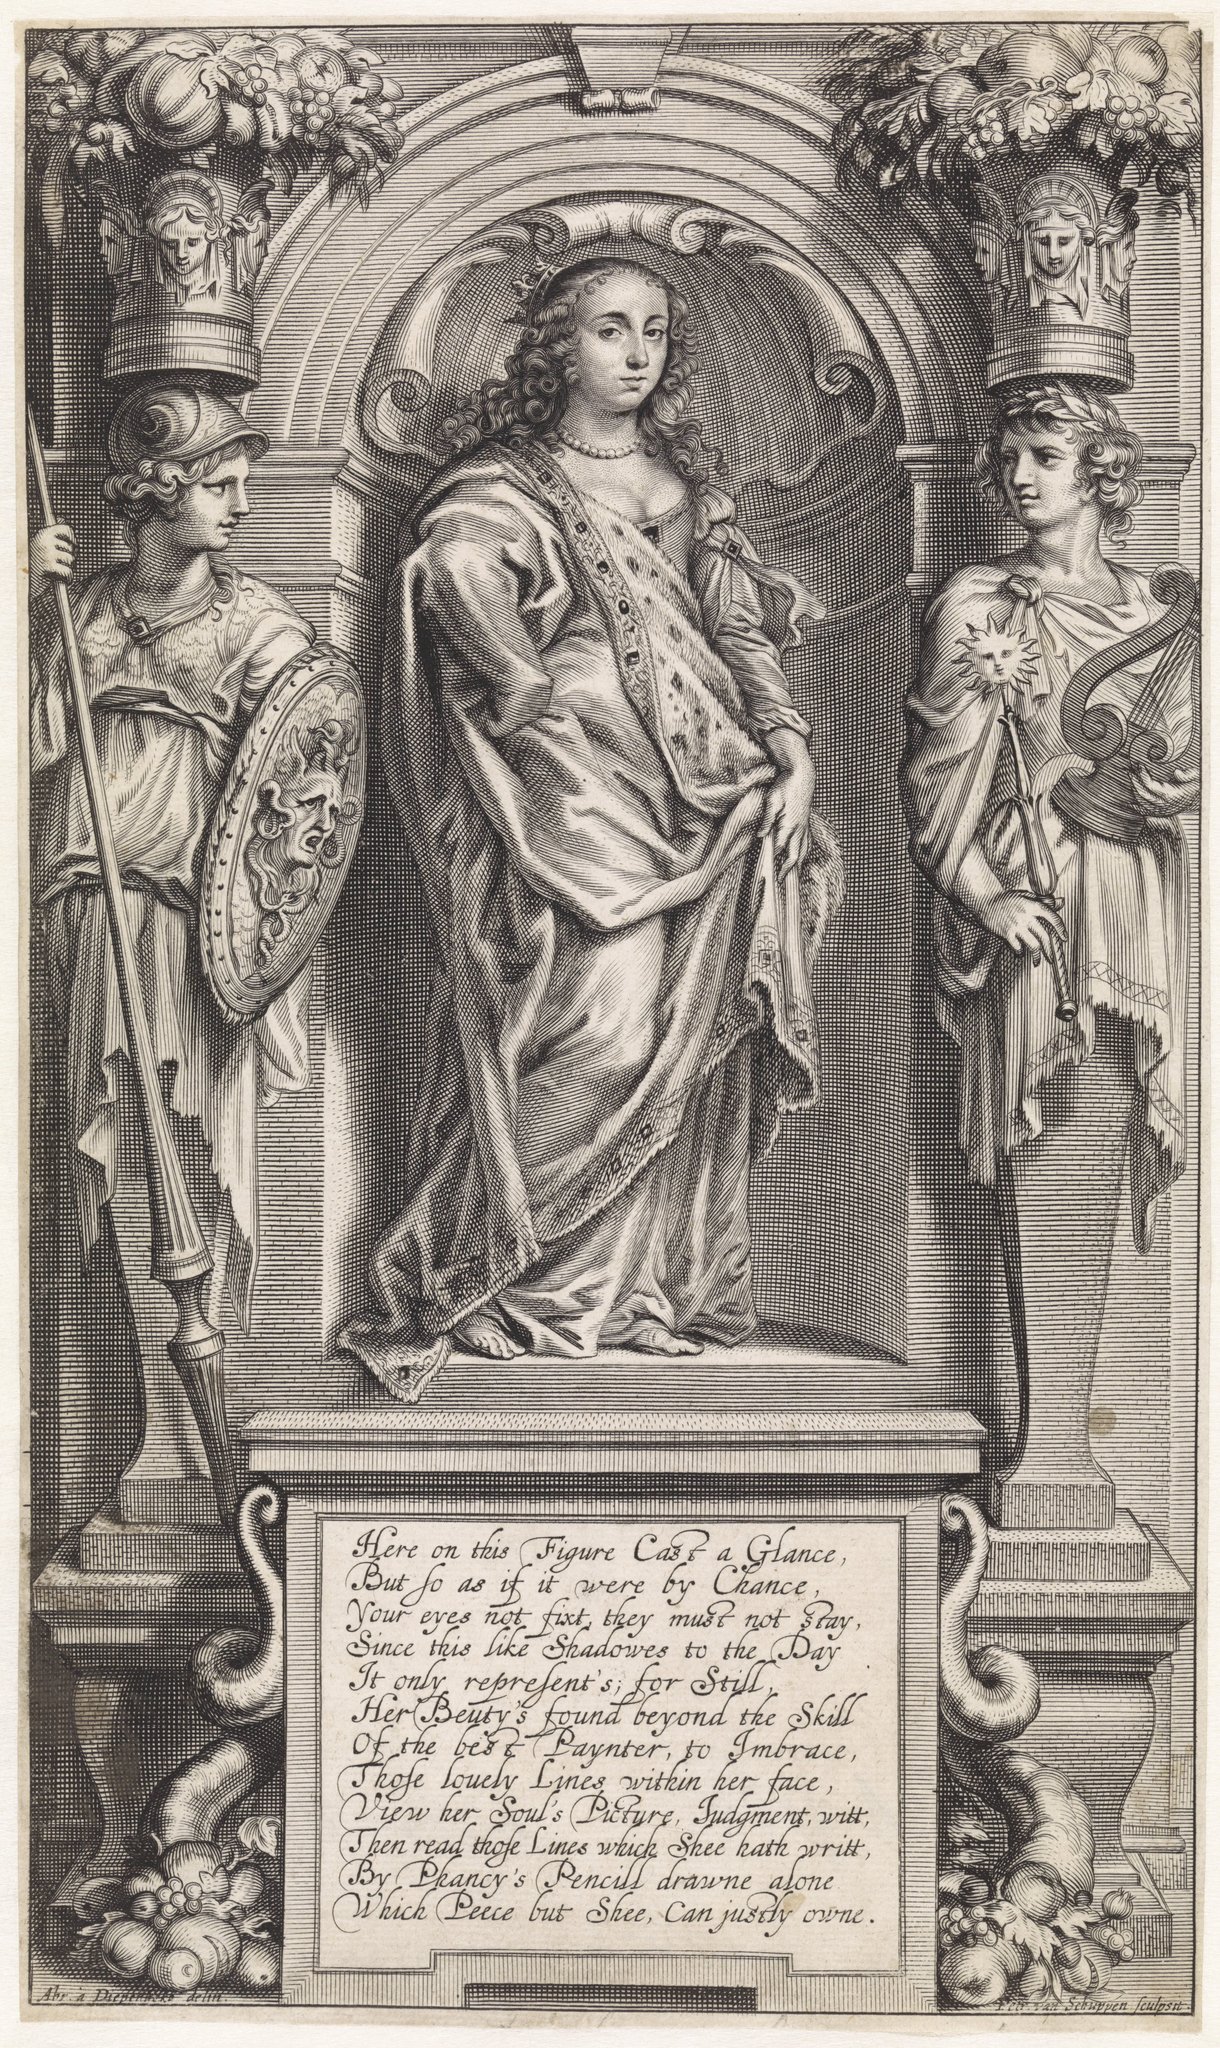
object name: print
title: Portret van Margaret Lucas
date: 1645-1673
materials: paper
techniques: engraving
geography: paris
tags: caryatids ~ architecture, portrait of a writer, specific aspects, allegorical aspects of minerva; minerva as patroness, specific aspects, allegorical aspects of apollo; apollo as patron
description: Portret van Margaret Lucas. Zij draagt een mantel afgezet met edelstenen en bont en een kroontje op het hoofd. Aan haar blote voeten sandaaltjes. Ze staat in een nis met aan weerszijden Minerva en Apollo in de vorm van kariatiden, als symbool voor kunst en wetenschap. Onder het portret een lofdicht in het Engels op haar innerlijke en uiterlijke schoonheid en een aansporing haar (literaire en wetenschappelijke) publicaties te lezen.